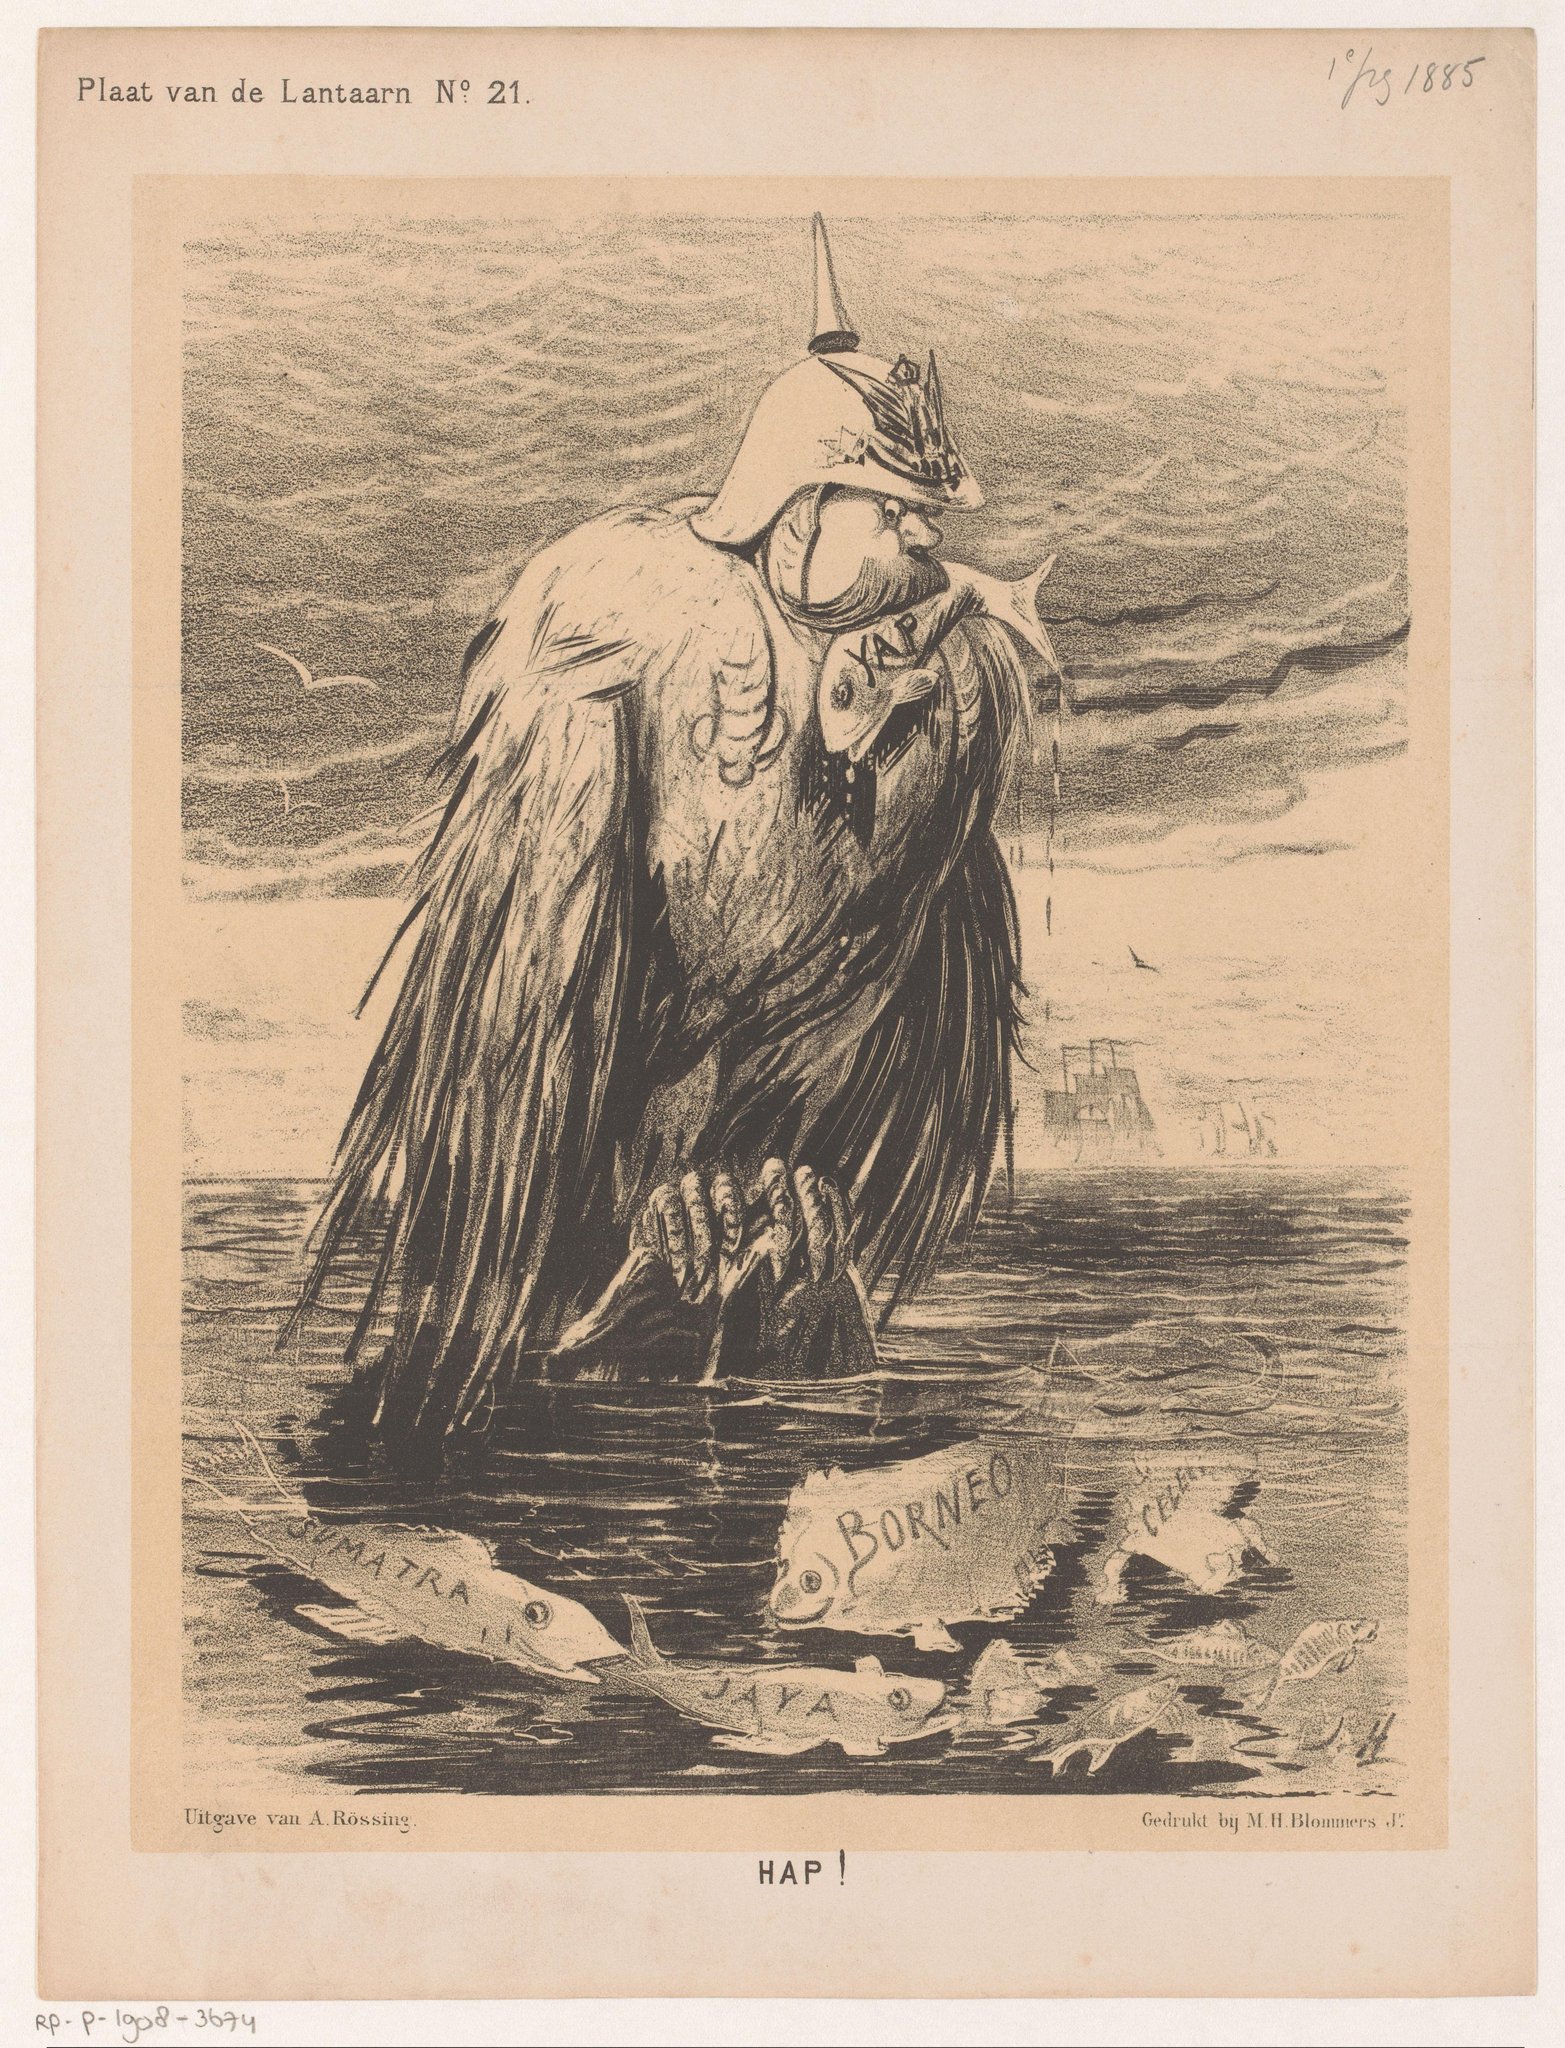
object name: cartoon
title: Spotprent over ontstaan Bismarck-archipel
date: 1885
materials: paper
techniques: tone lithography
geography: the hague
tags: predatory birds: eagle, political caricatures and satires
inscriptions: collector's mark: Lugt 2228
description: Otto van Bismarck, hier in de vorm van een adelaar, eet een vis uit de zee. Deze andere vissen verbeelden de eilandengroep ten noordoosten van (en behorend bij) Papoea-Nieuw-Guinea. In 1884 werden deze eilanden geannexeerd door Duitsland en werden ze vernoemd naar bondskanselier Bismarck. Deze prent werd uitgegeven bij De Lantaarn.